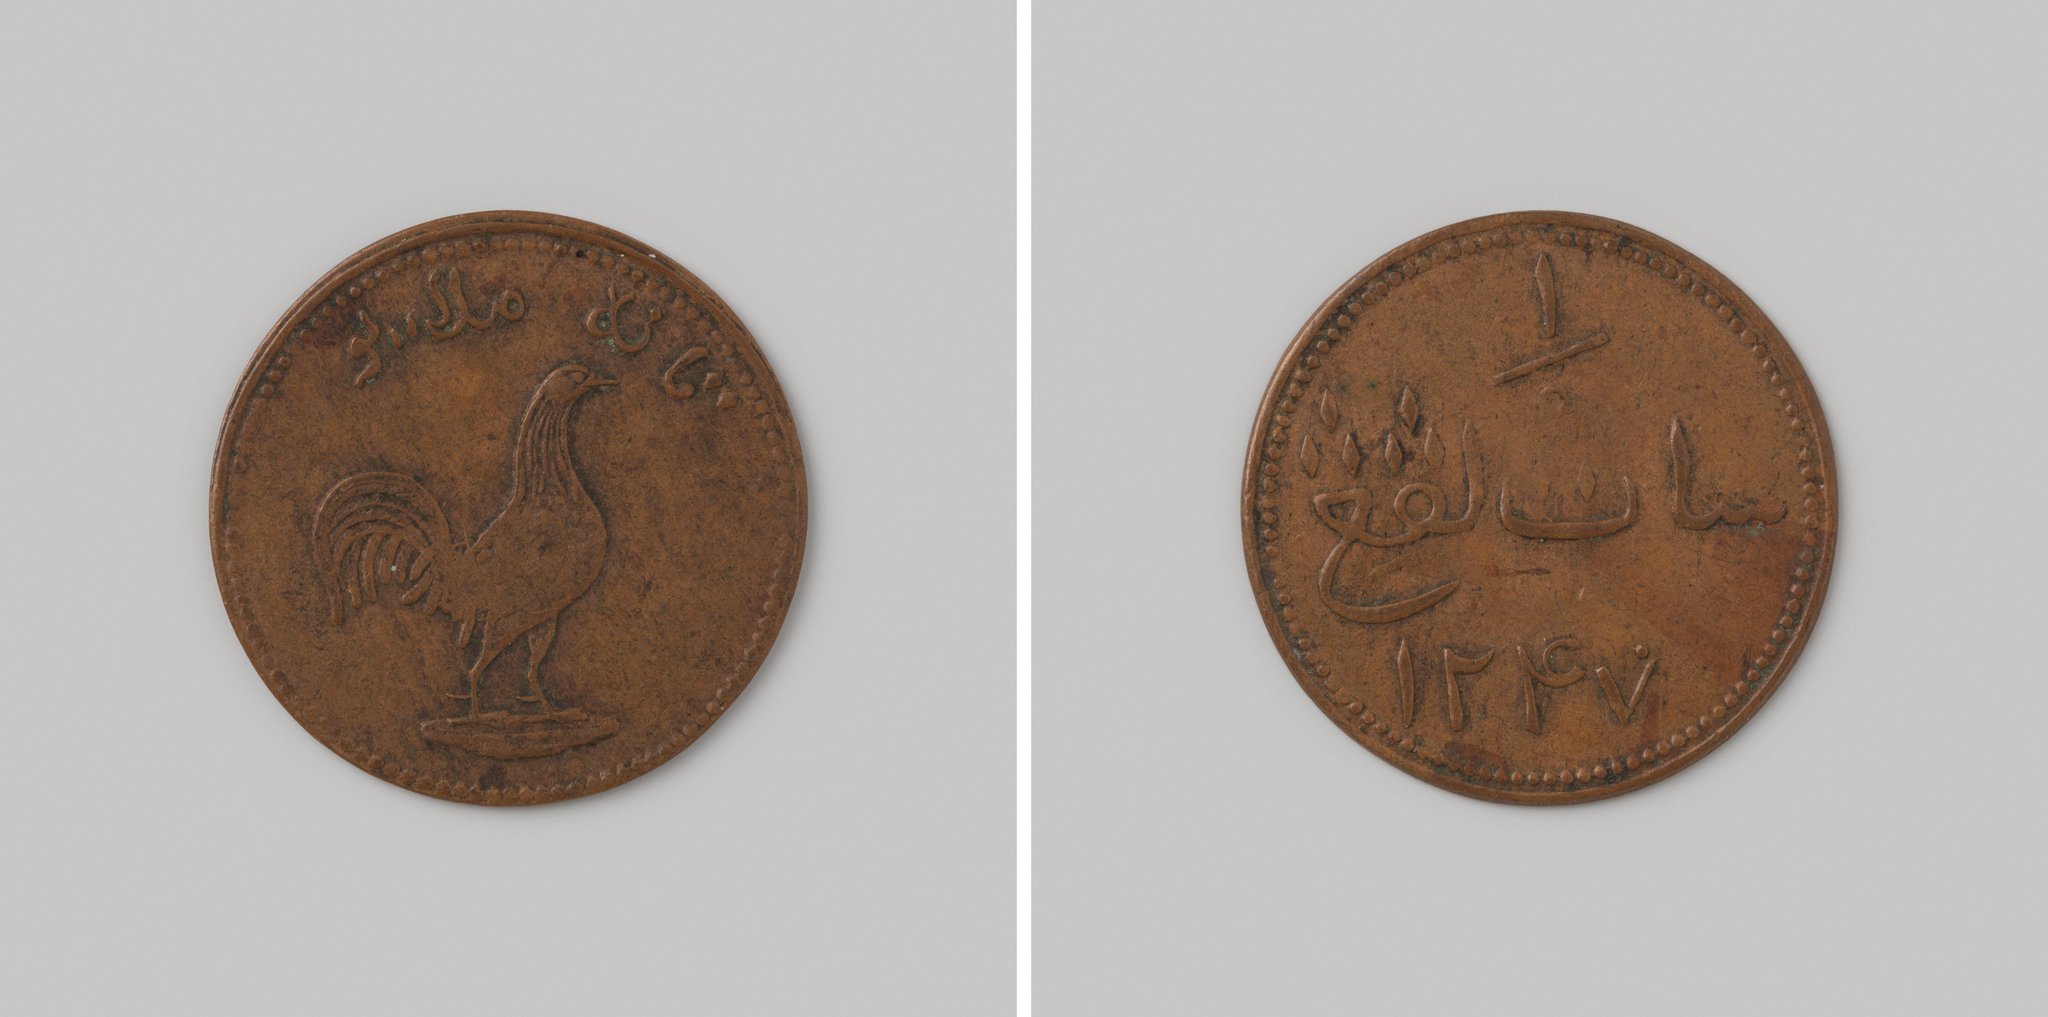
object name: coin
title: Kepeng of haantjesduit uit Malakka, 1247 [=1831]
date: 1831-1832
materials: copper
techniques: striking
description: Koperen particuliere munt. Voorzijde: staande haan naar rechts. Daarboven omschrift in Arabische lettertekens: tanu Malayu. Keerzijde: in een regel waarde-aaanduiding sat kepeng in Arabische lettertekens, waarboven 1/1. Jaartal: 1247 onderaan. Gladde rand.